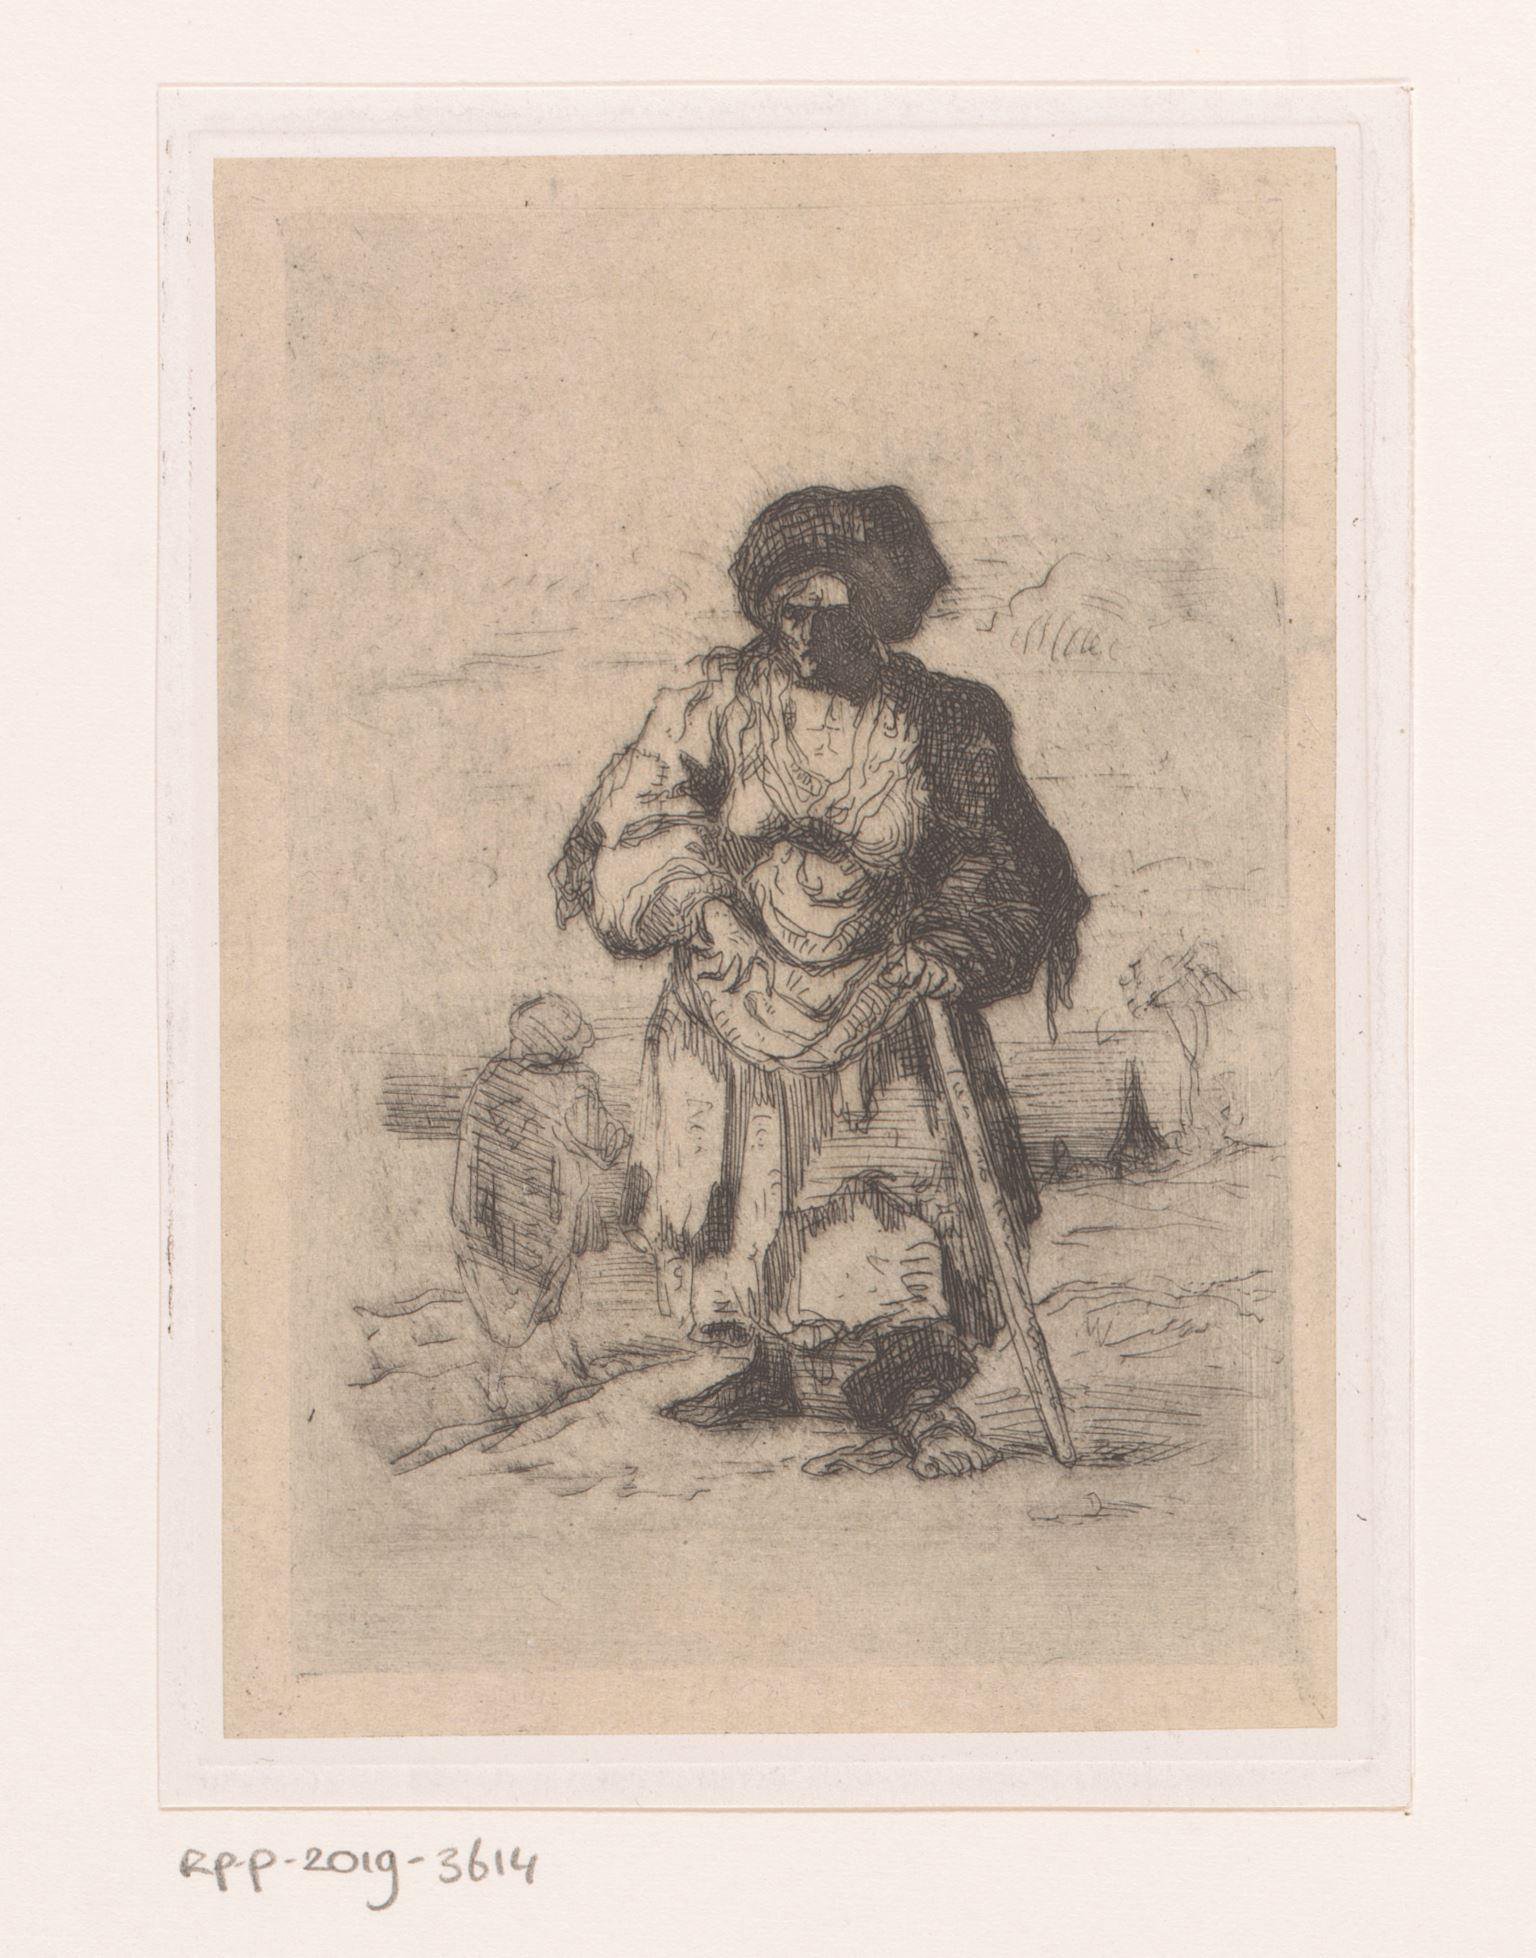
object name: print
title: Vlaamse bedelaar met wandelstok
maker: van den kerckhoven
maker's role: print maker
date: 1847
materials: paper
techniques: etching, intaglio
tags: beggar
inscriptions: collector's mark: Lugt 2228